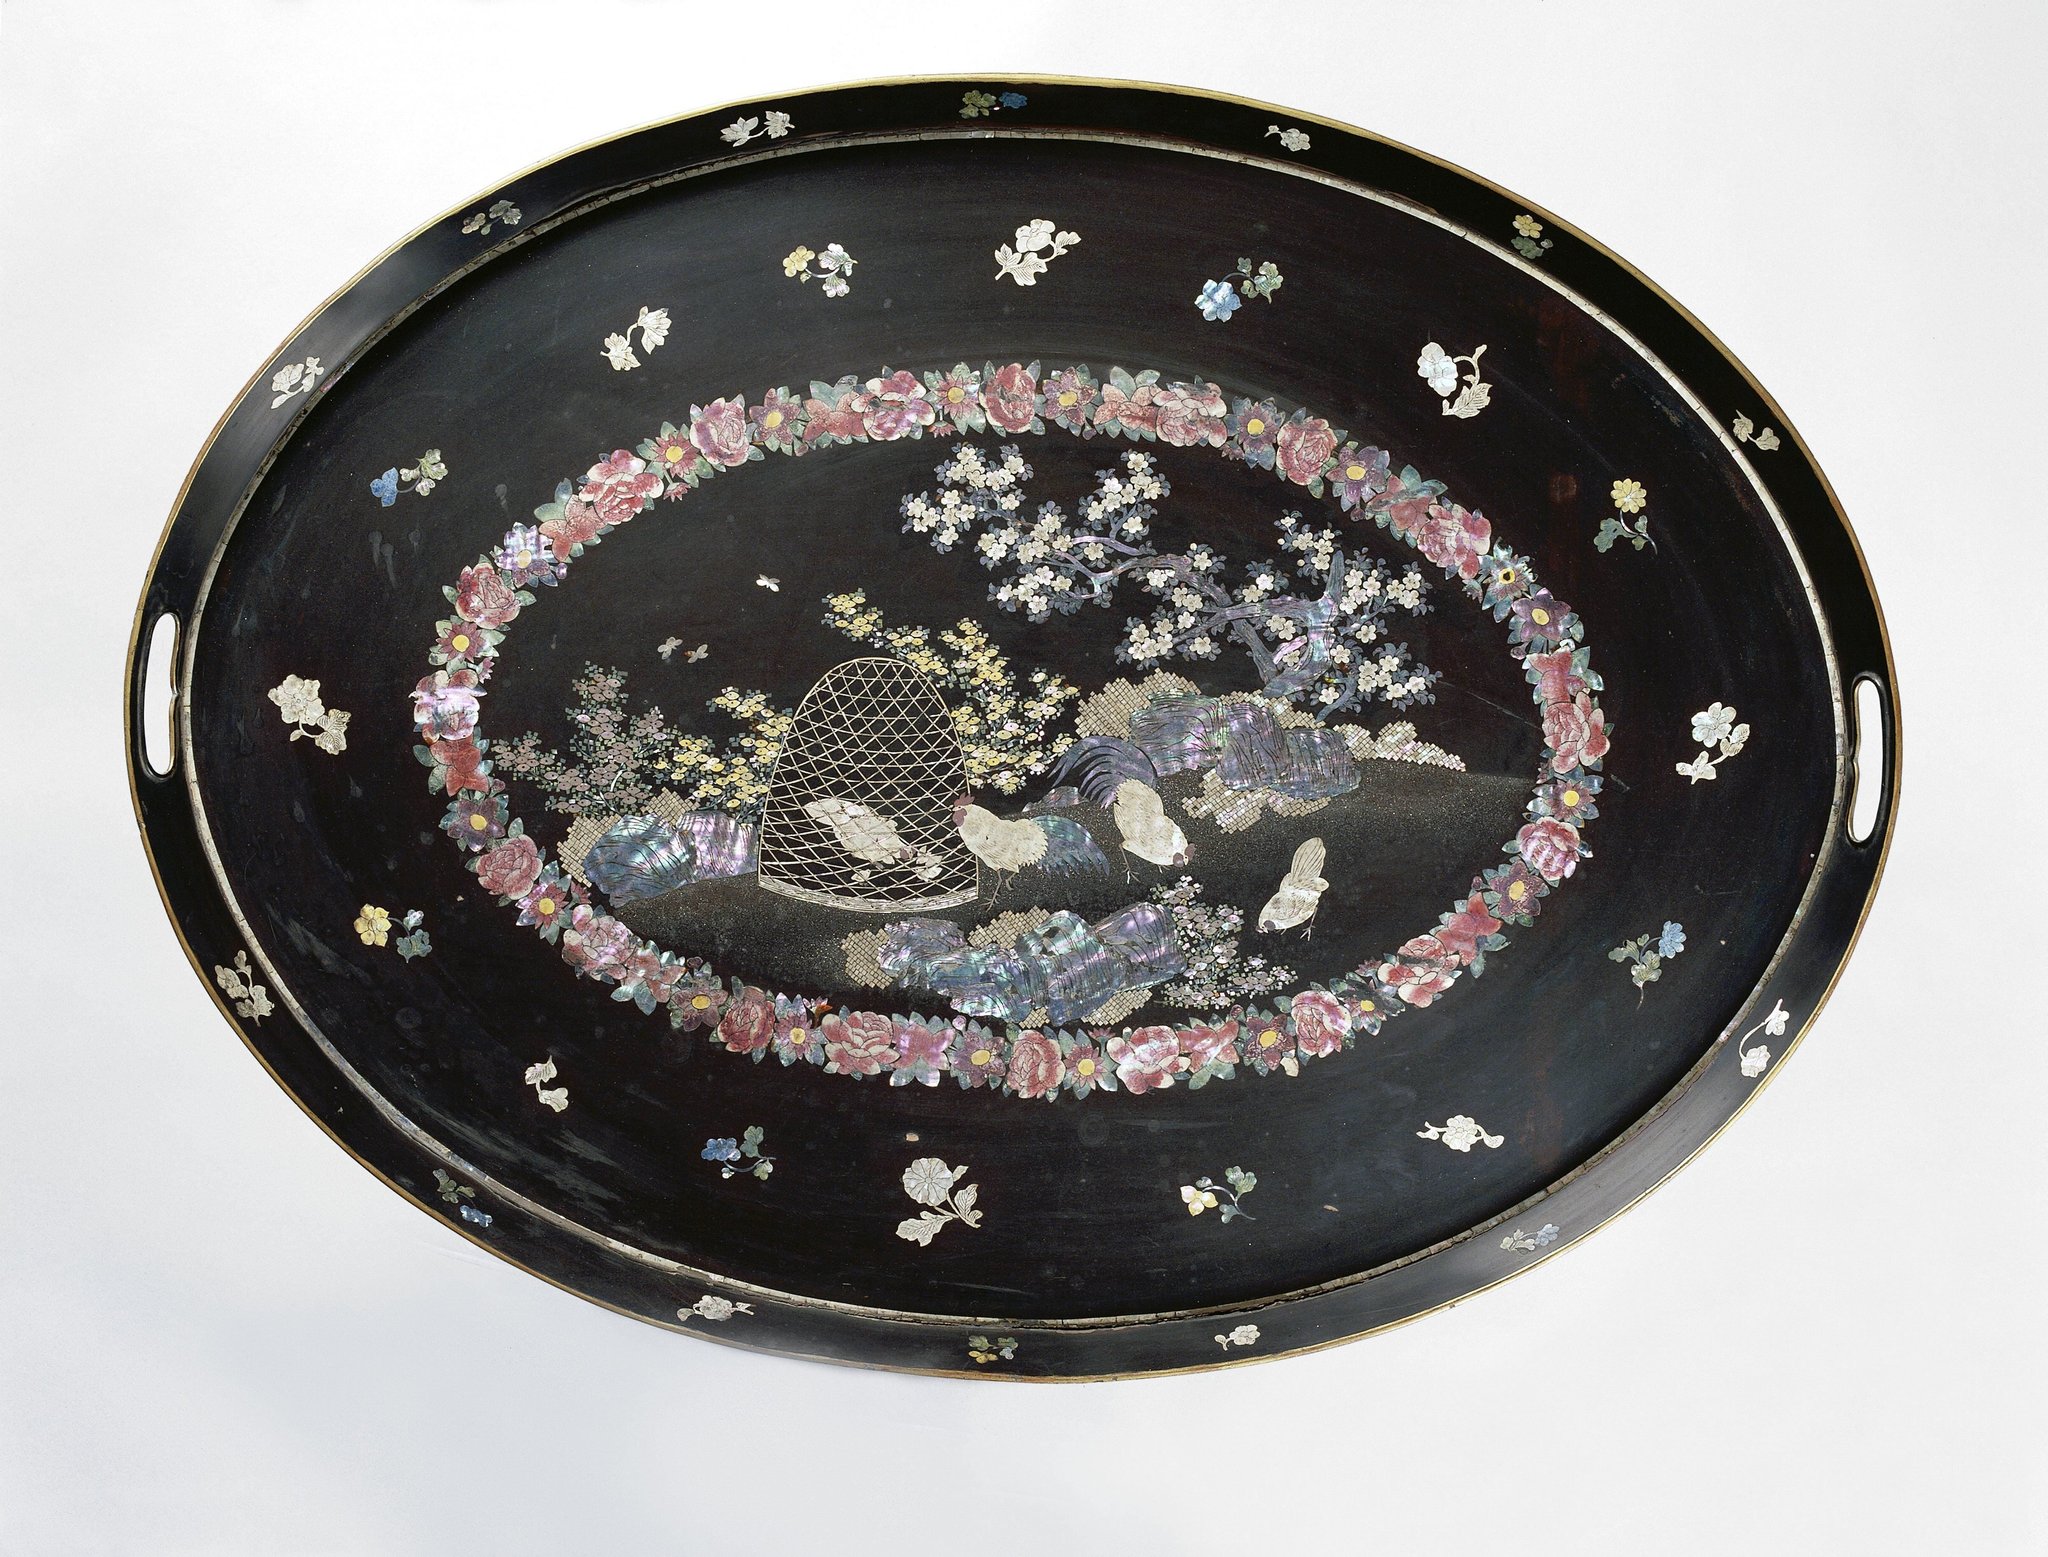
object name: schenkblad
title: Ovaal blad, lakwerk met parelmoer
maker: Anonymous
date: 1820-1825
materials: copper, lacquer, mother of pearl, wood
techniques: lacquer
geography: japan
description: Ovaal blad met een opstaande rand. lakwerk met inlegwerk van parelmoer. In het centrum kippen bij een kooi en bij bloeiende planten. de voorstelling wordt omgeven door een band van rozen. Daarbuiten strooibloemen.